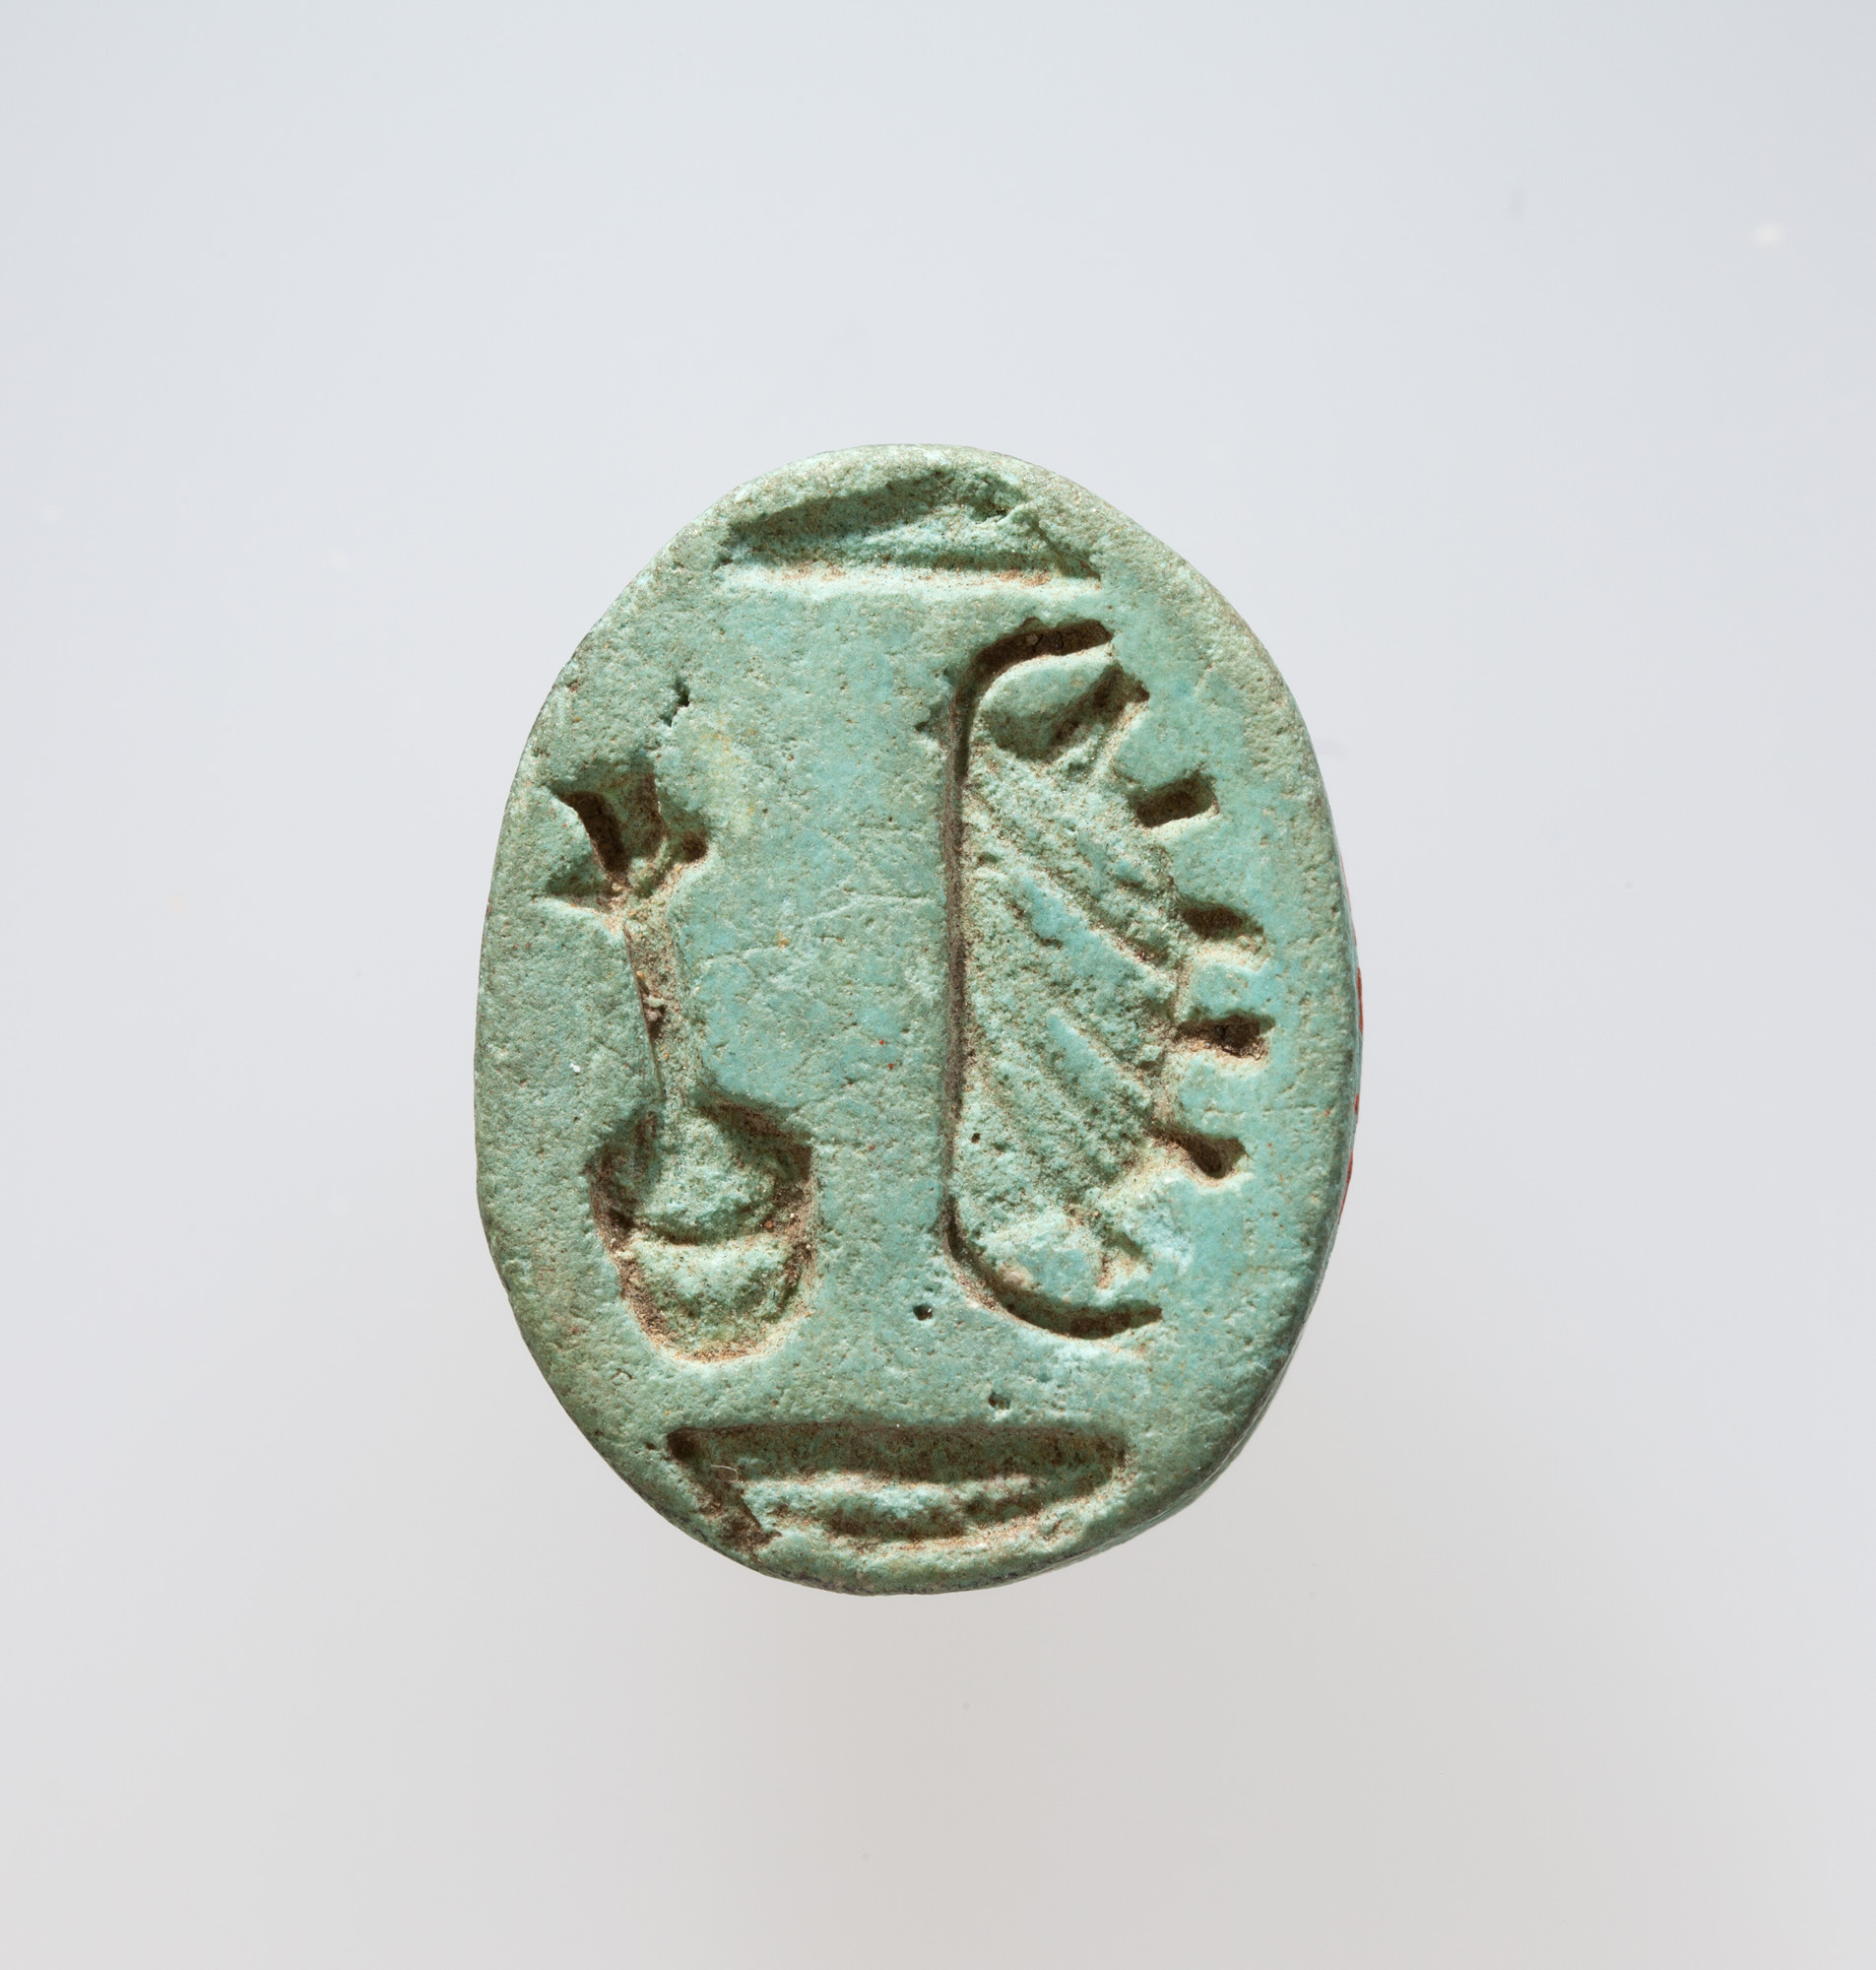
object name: scarab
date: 1479-1458 BCE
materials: faience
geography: egypt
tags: scarabs